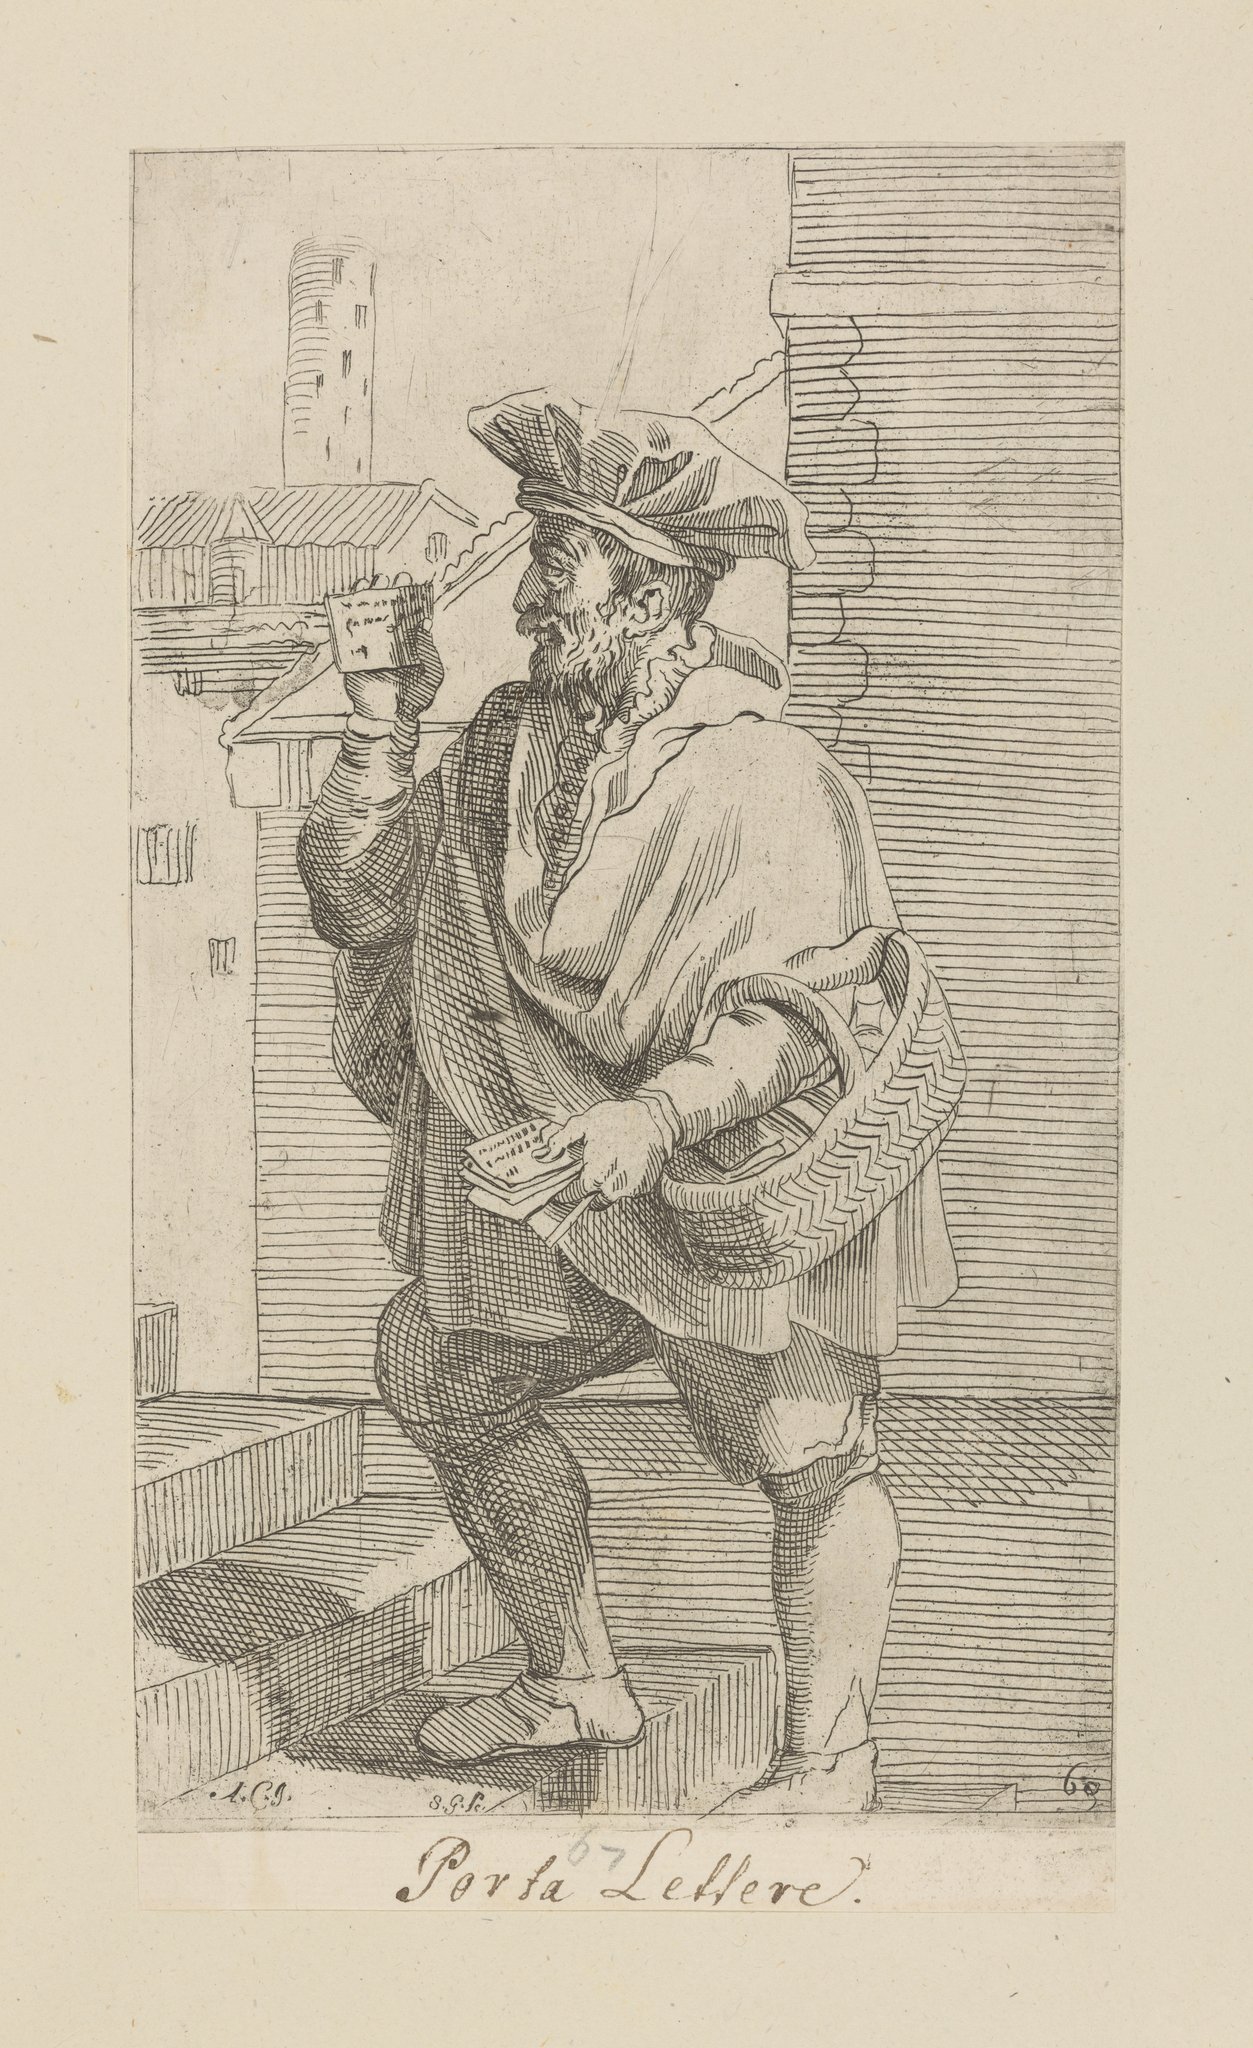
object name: print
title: Plate 63: Postman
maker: simon guillain ii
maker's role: artist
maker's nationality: french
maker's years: 1618-1718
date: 1646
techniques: etching